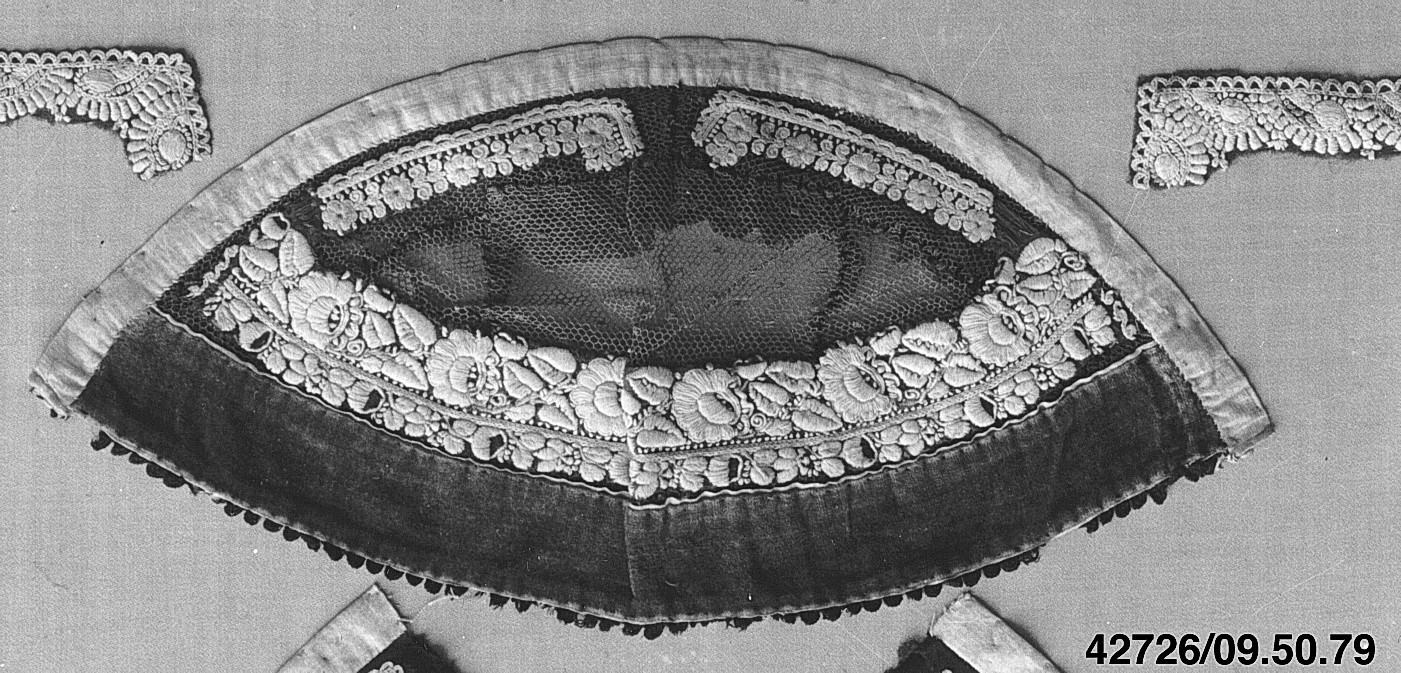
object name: fragment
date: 1801-1833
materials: silk